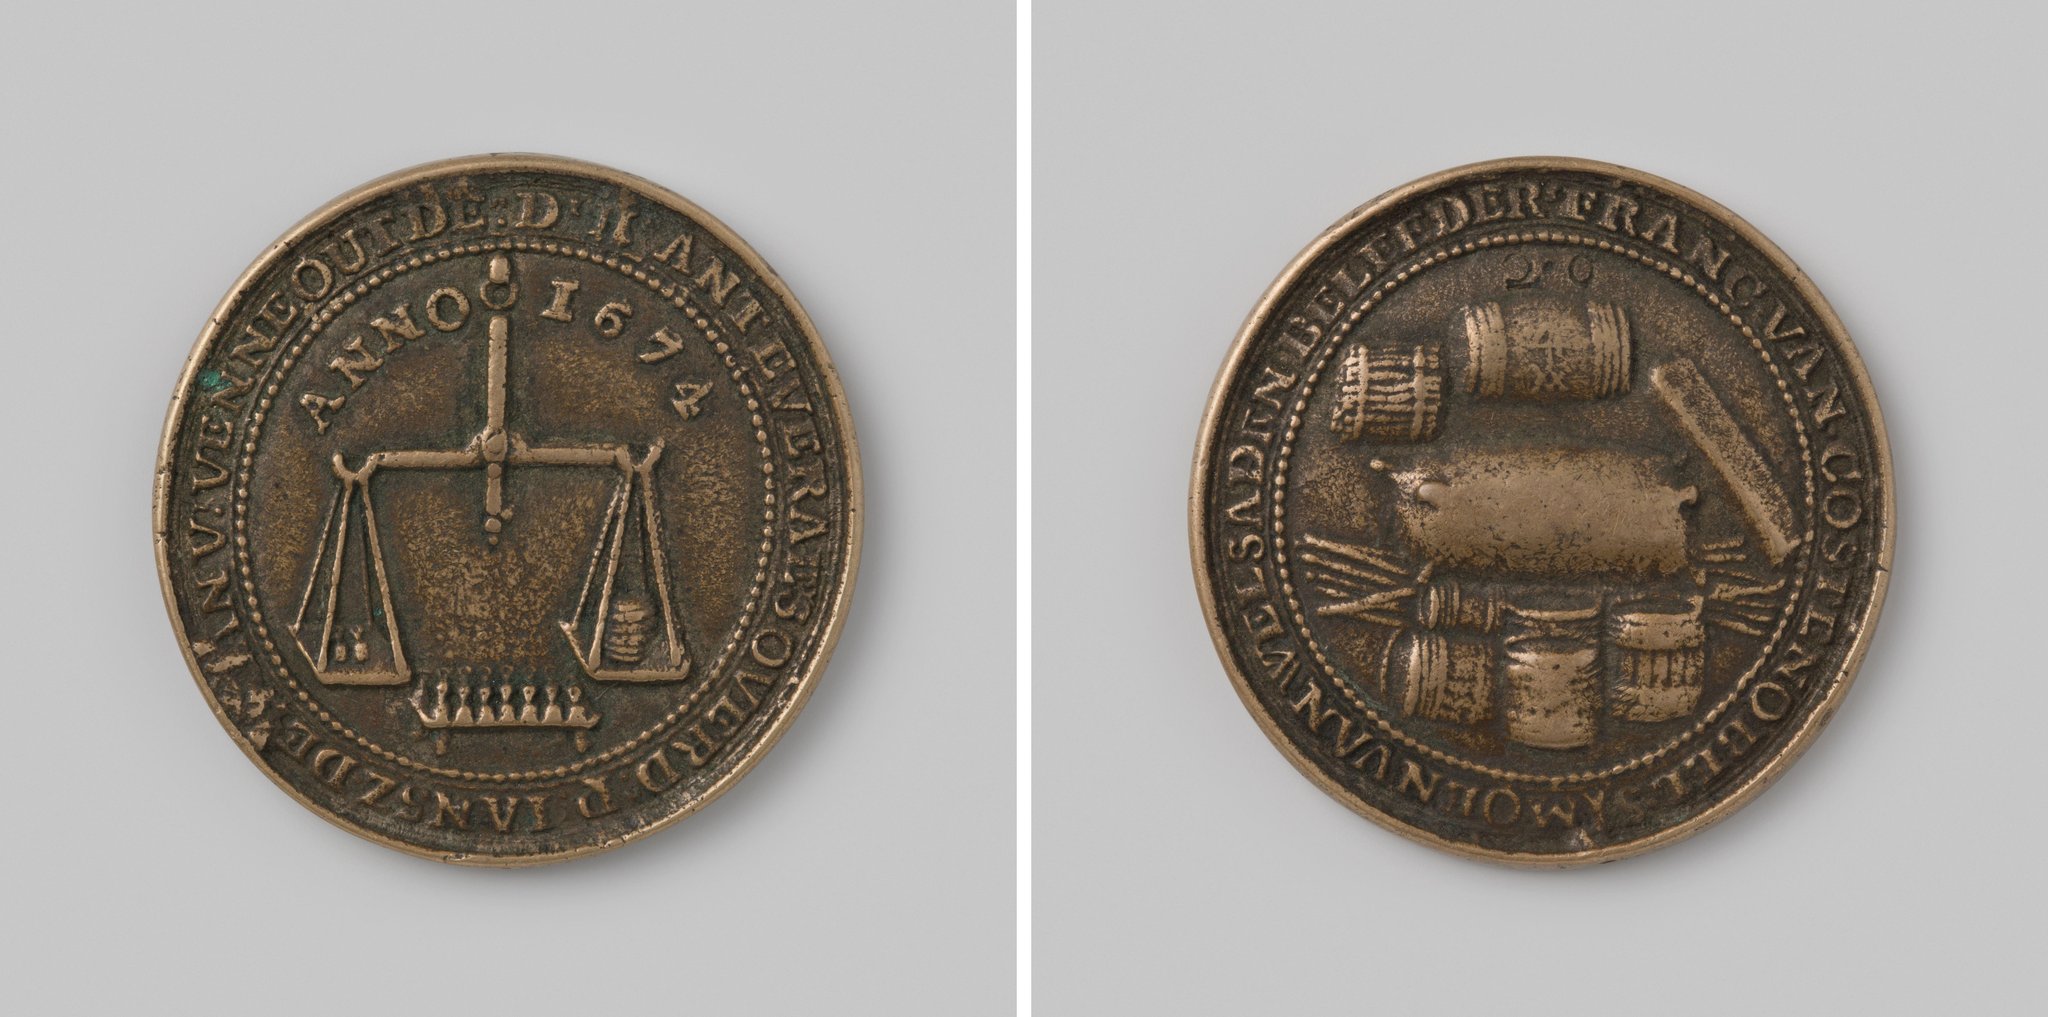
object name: medal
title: Presentiepenning van het Waagwerkersgilde te Middelburg 1674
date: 1674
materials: brass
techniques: casting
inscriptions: circumscription: ‘FRANC VAN COSTENOBEL SIMOEN VAN WELSADEN BELEEDERS’, inscription: ‘20’, circumscription: ‘D H ANT EVERAES OVERD P IANSZ DEK IAN V VENNE OUTDE’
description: Gegoten messing penning, op de voorzijde een balans met rekje gewichten onder ANNO 1674, met omschrift, op de keerzijde vaten balen en bundels, met omschrift, ingestempeld het getal 20